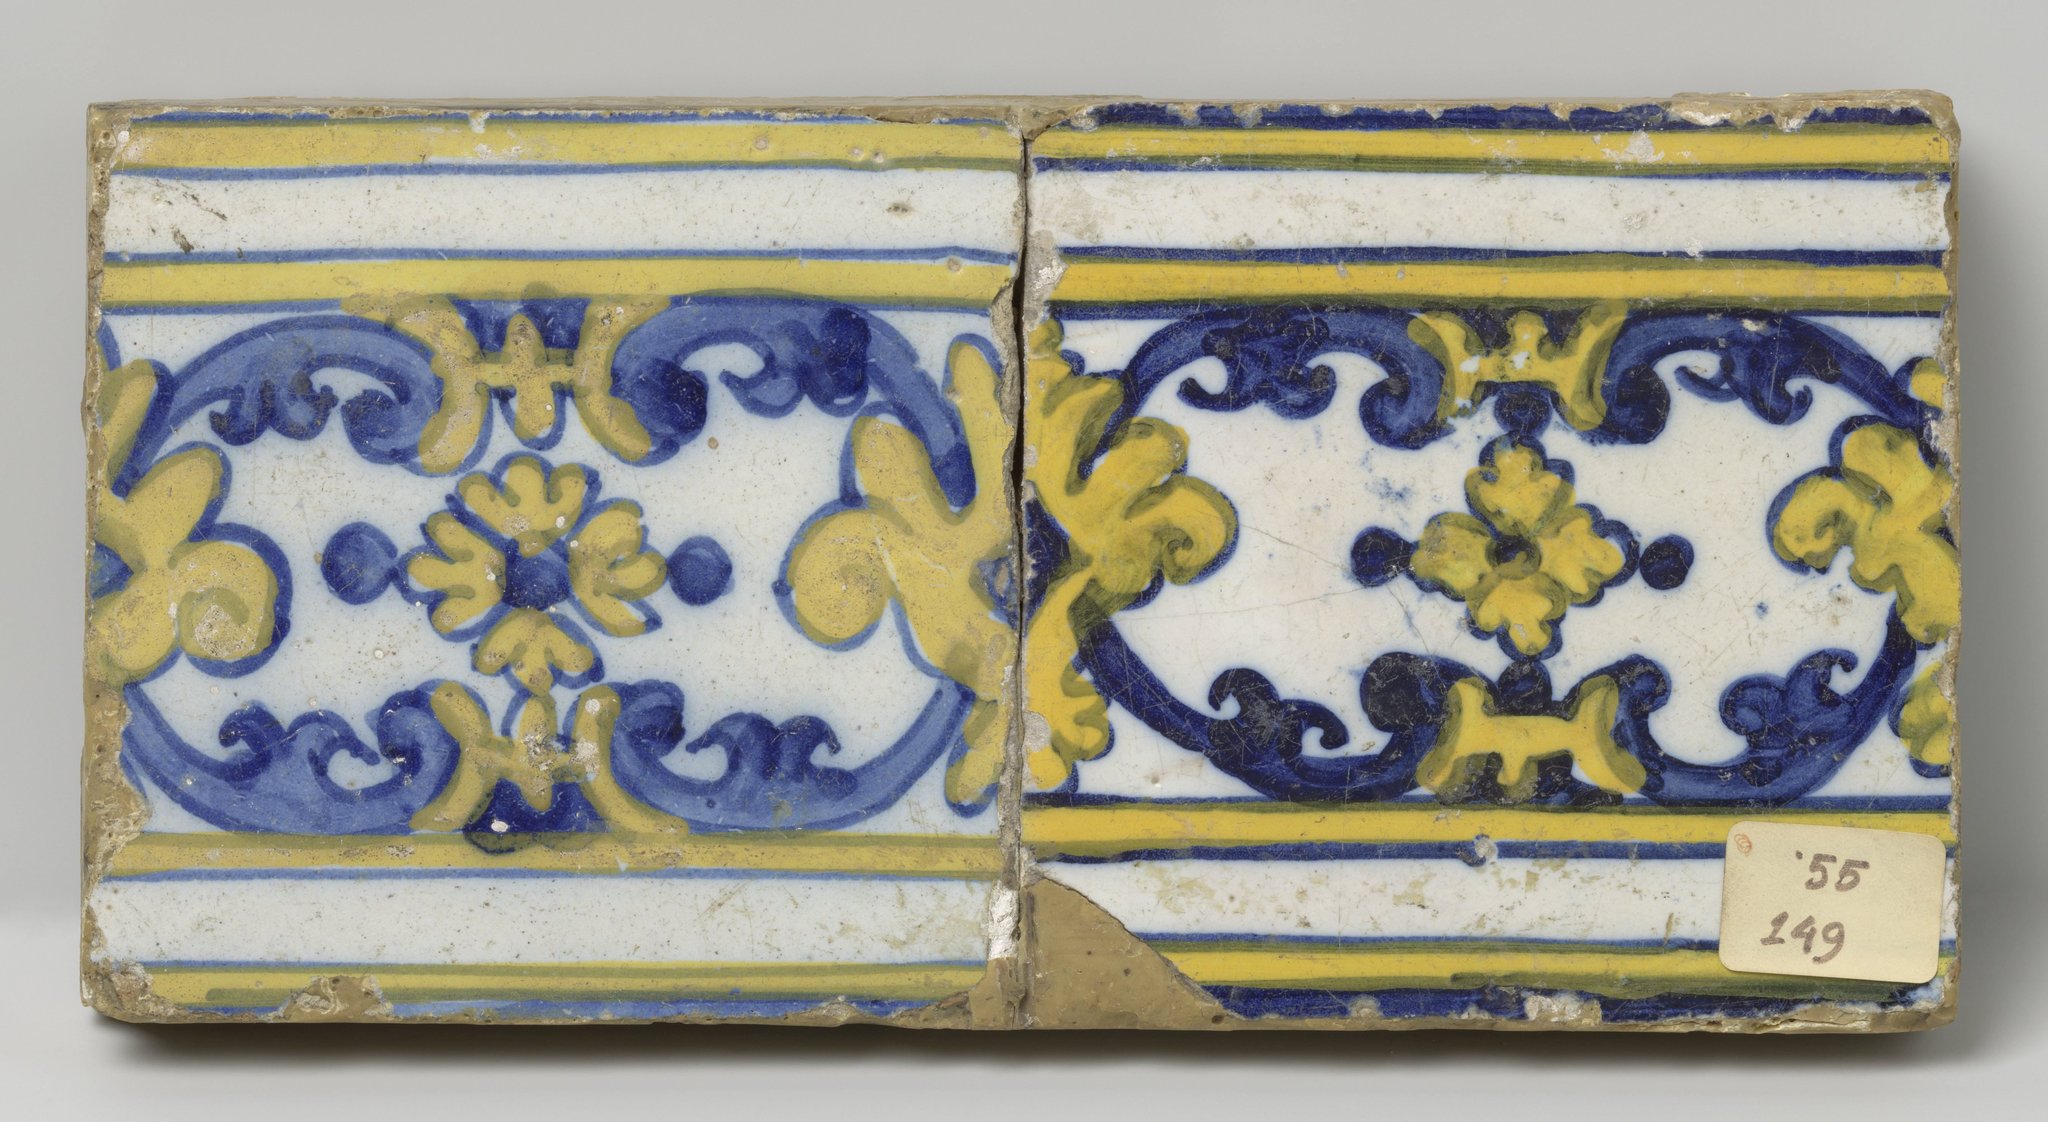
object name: randtegel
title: Veld van twee randtegels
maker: Anonymous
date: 1600-1625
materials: earthenware, glaze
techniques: maiolica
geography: portugal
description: Veld van twee randtegels (1 x 2) veelkleurig (geel en blauw) beschilderd met naar elkaar toegewende C-motieven tussen twee banden.